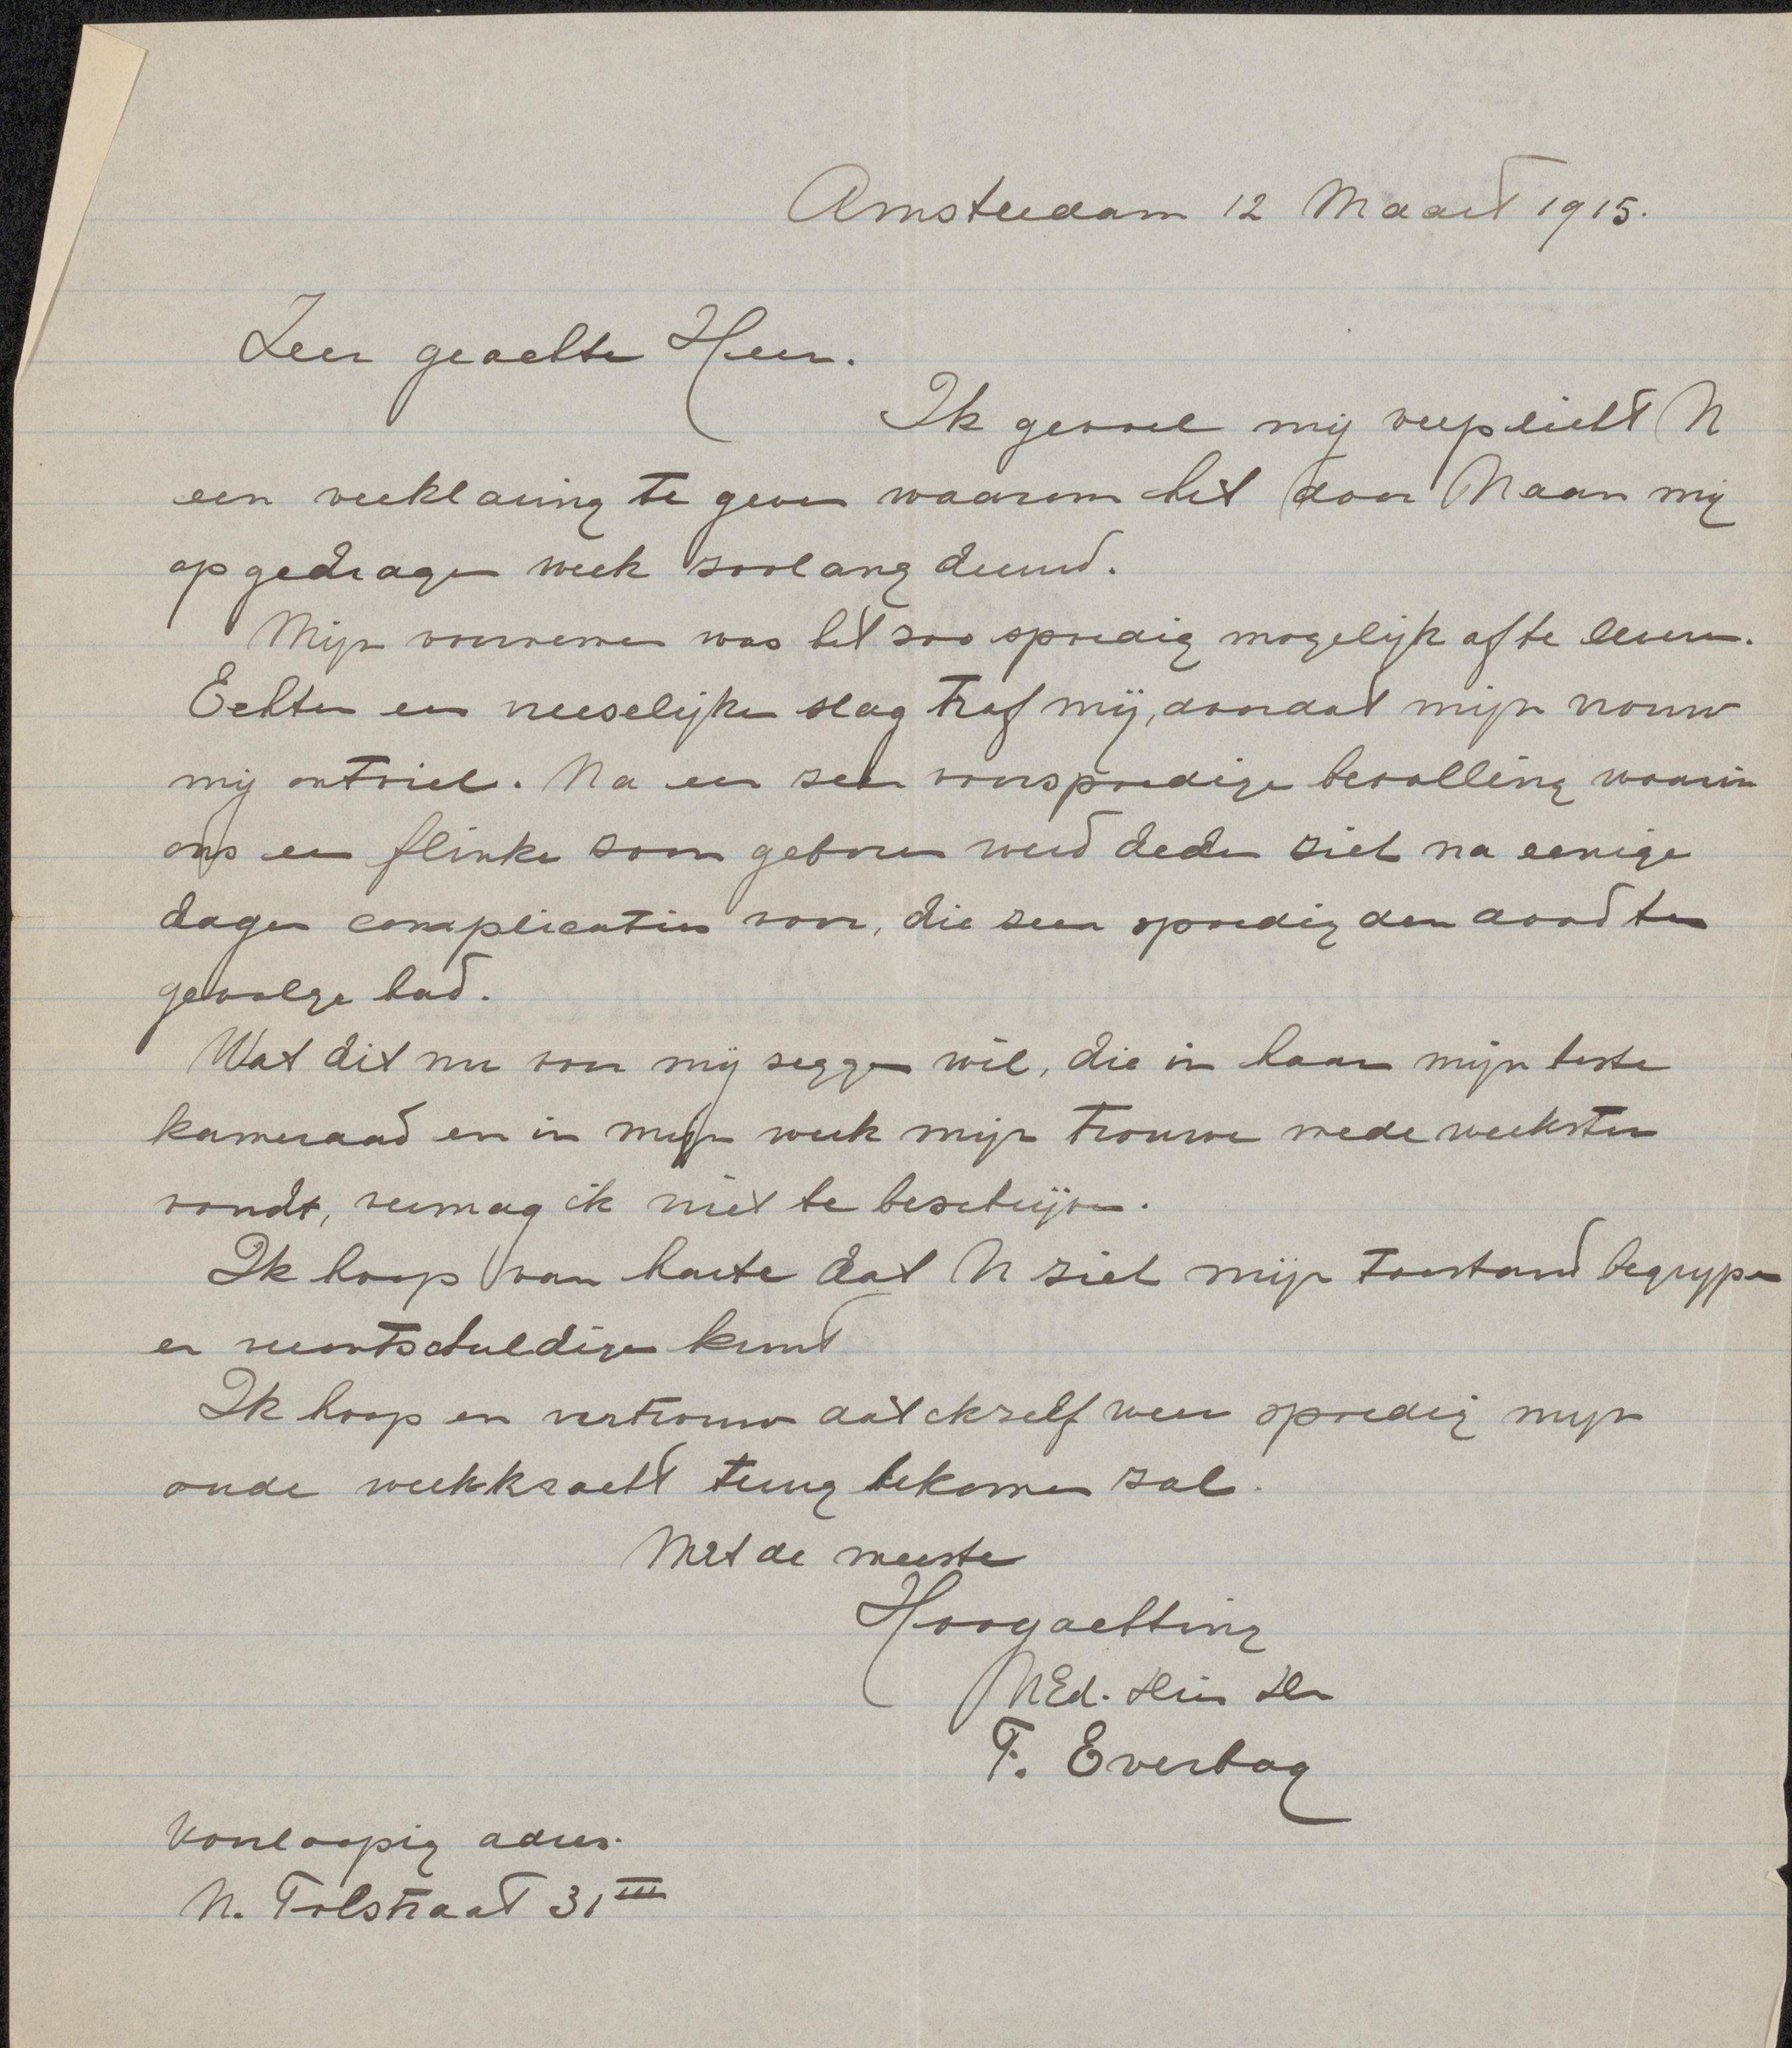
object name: letter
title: Brief aan jonkheer Hendrik Teding van Berkhout (1879-1969)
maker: frans everbag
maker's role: draughtsman, print maker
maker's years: 1877-1947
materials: ink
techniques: pen, writing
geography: amsterdam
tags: haarlem, amsterdam, jonkheer hendrik teding van berkhout (1879-1969), family life, diseases